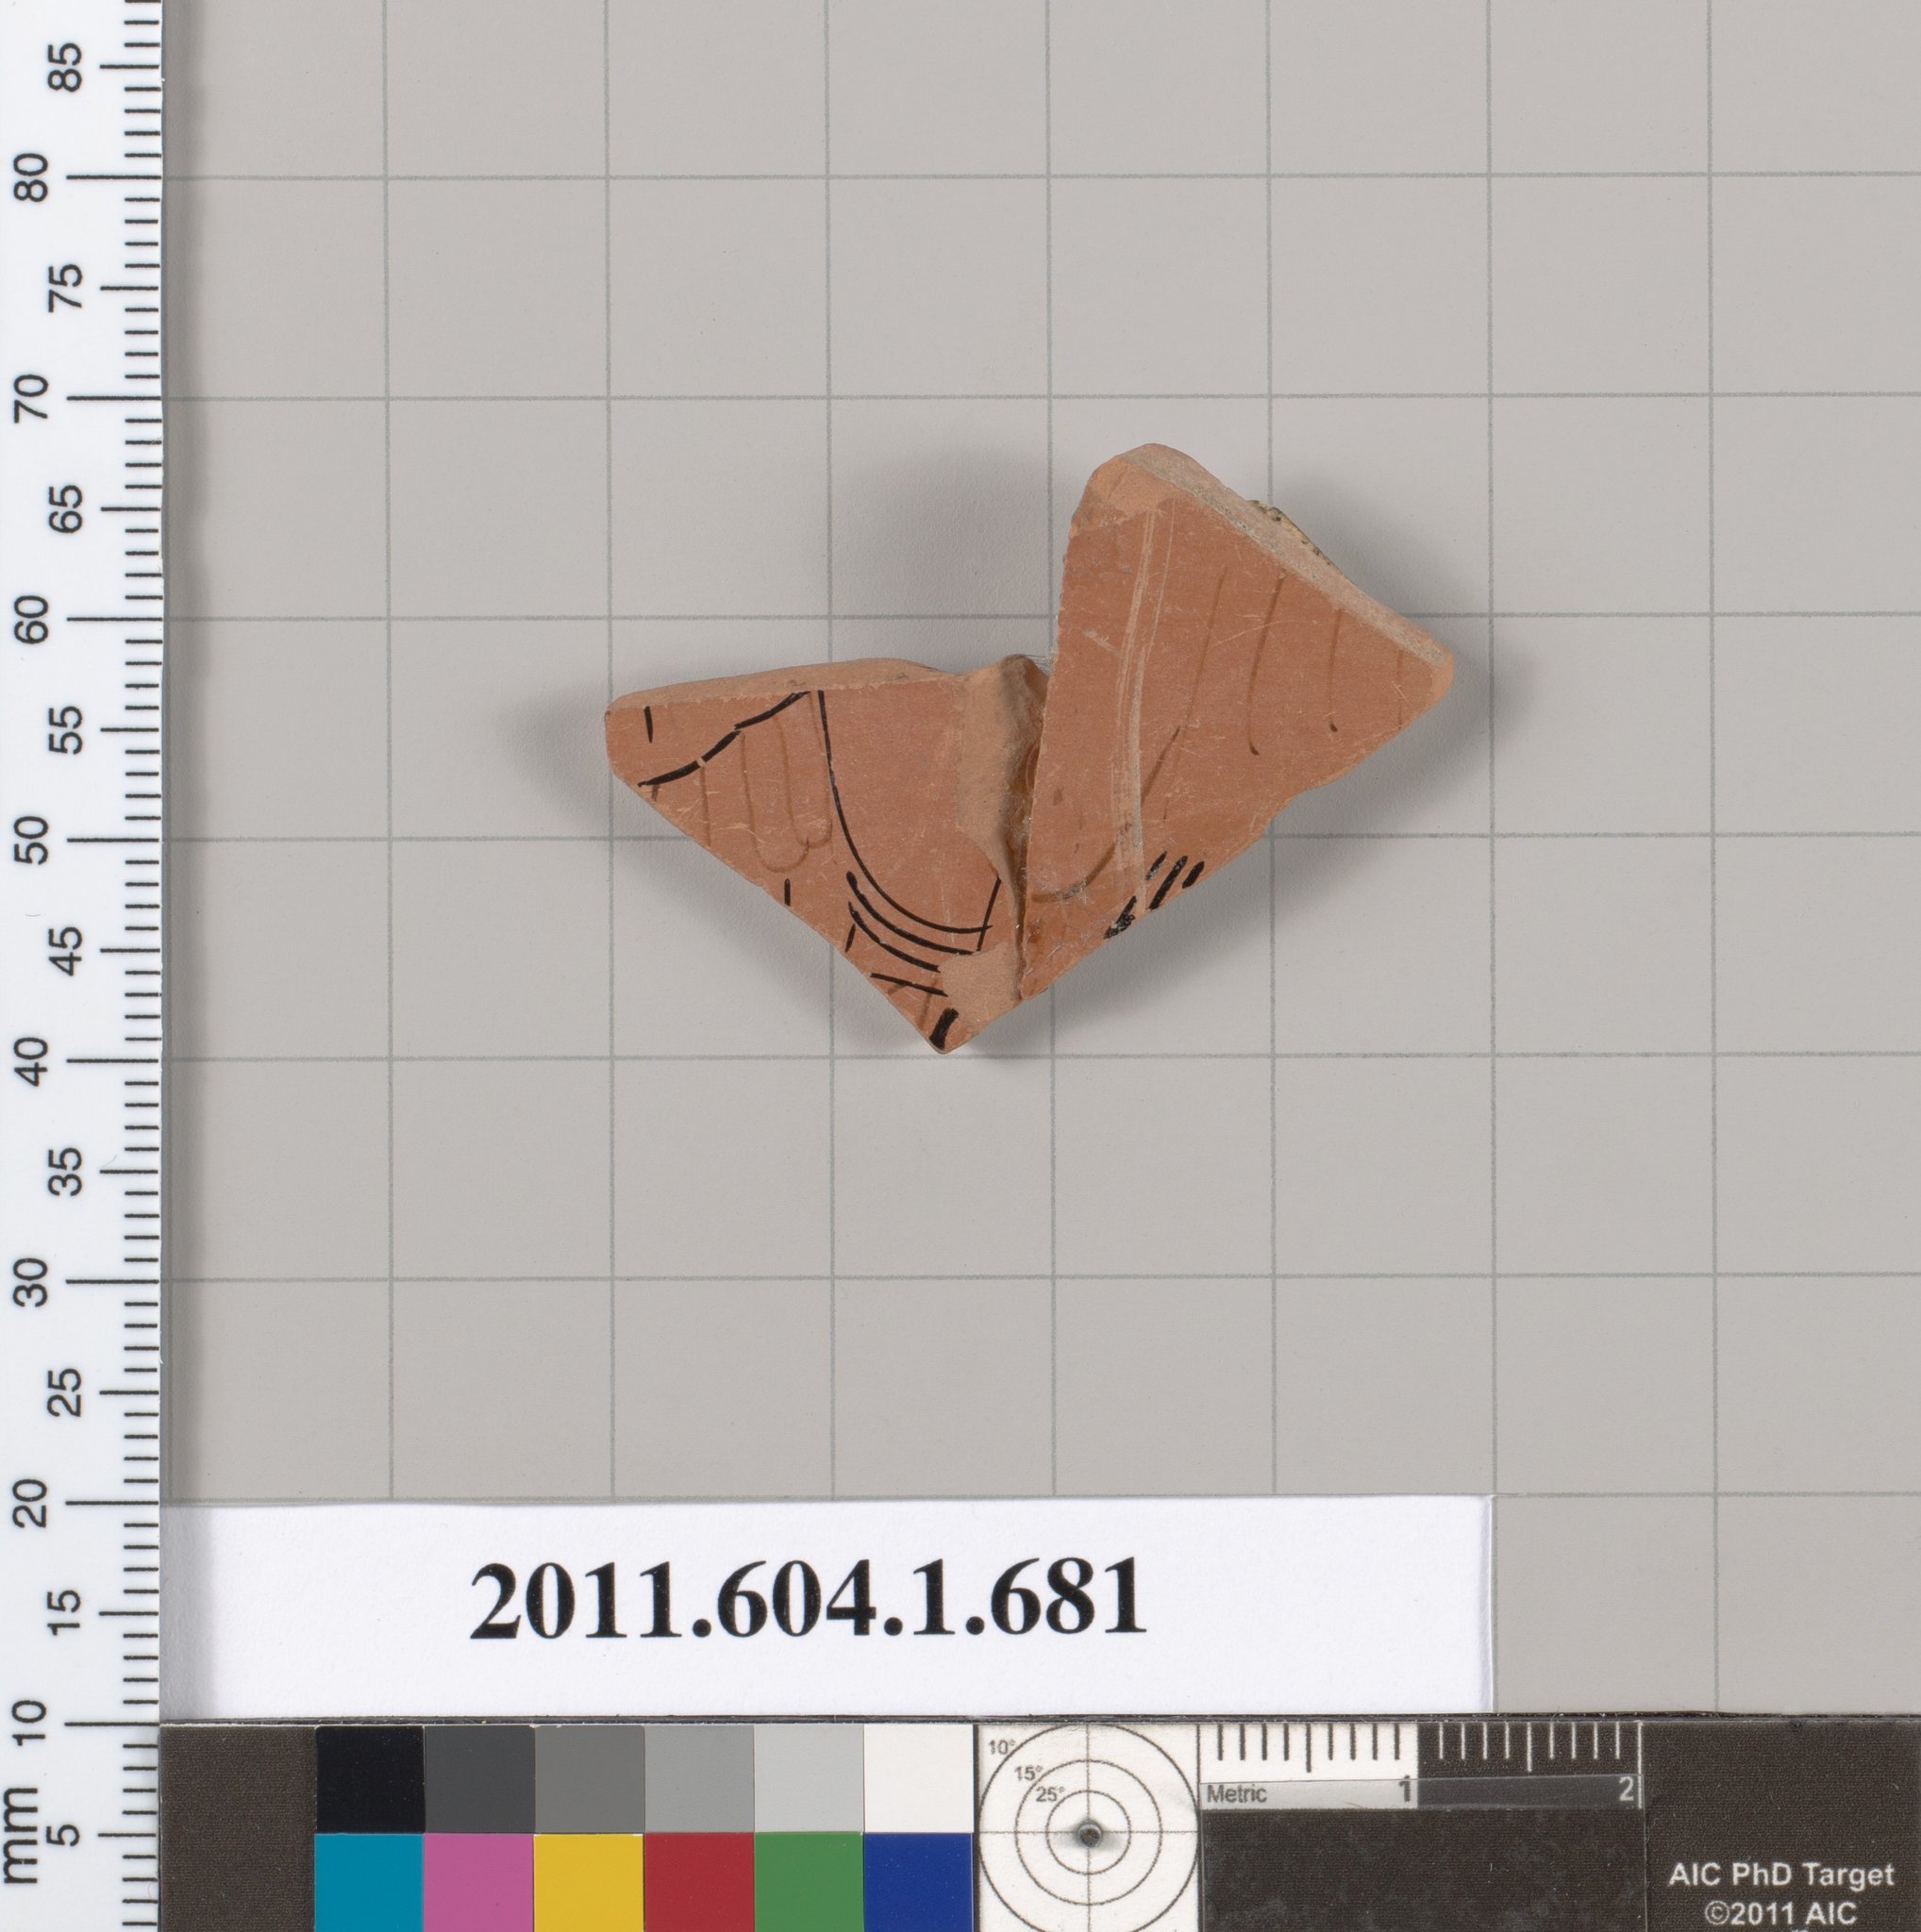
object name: kylix fragment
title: Terracotta fragment of a kylix (drinking cup)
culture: greek, attic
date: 475-451 BCE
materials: terracotta